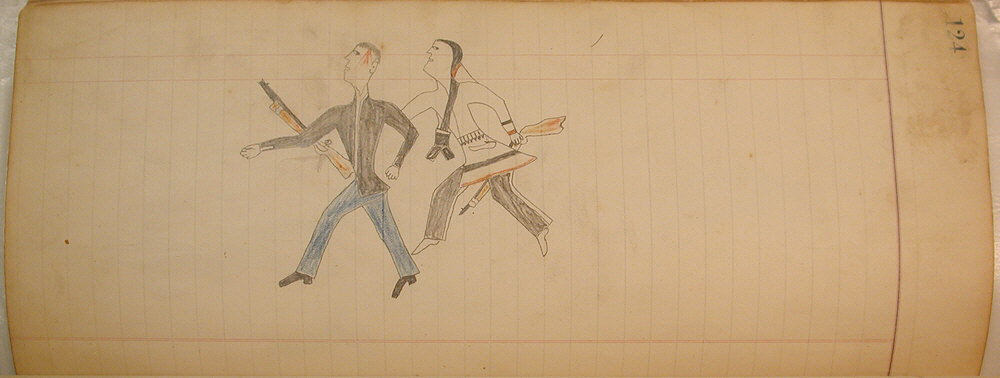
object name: drawing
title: Maffet Ledger: Drawing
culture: cheyenne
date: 1874-1881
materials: crayon, graphite, paper, watercolor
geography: united states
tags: firearms,men